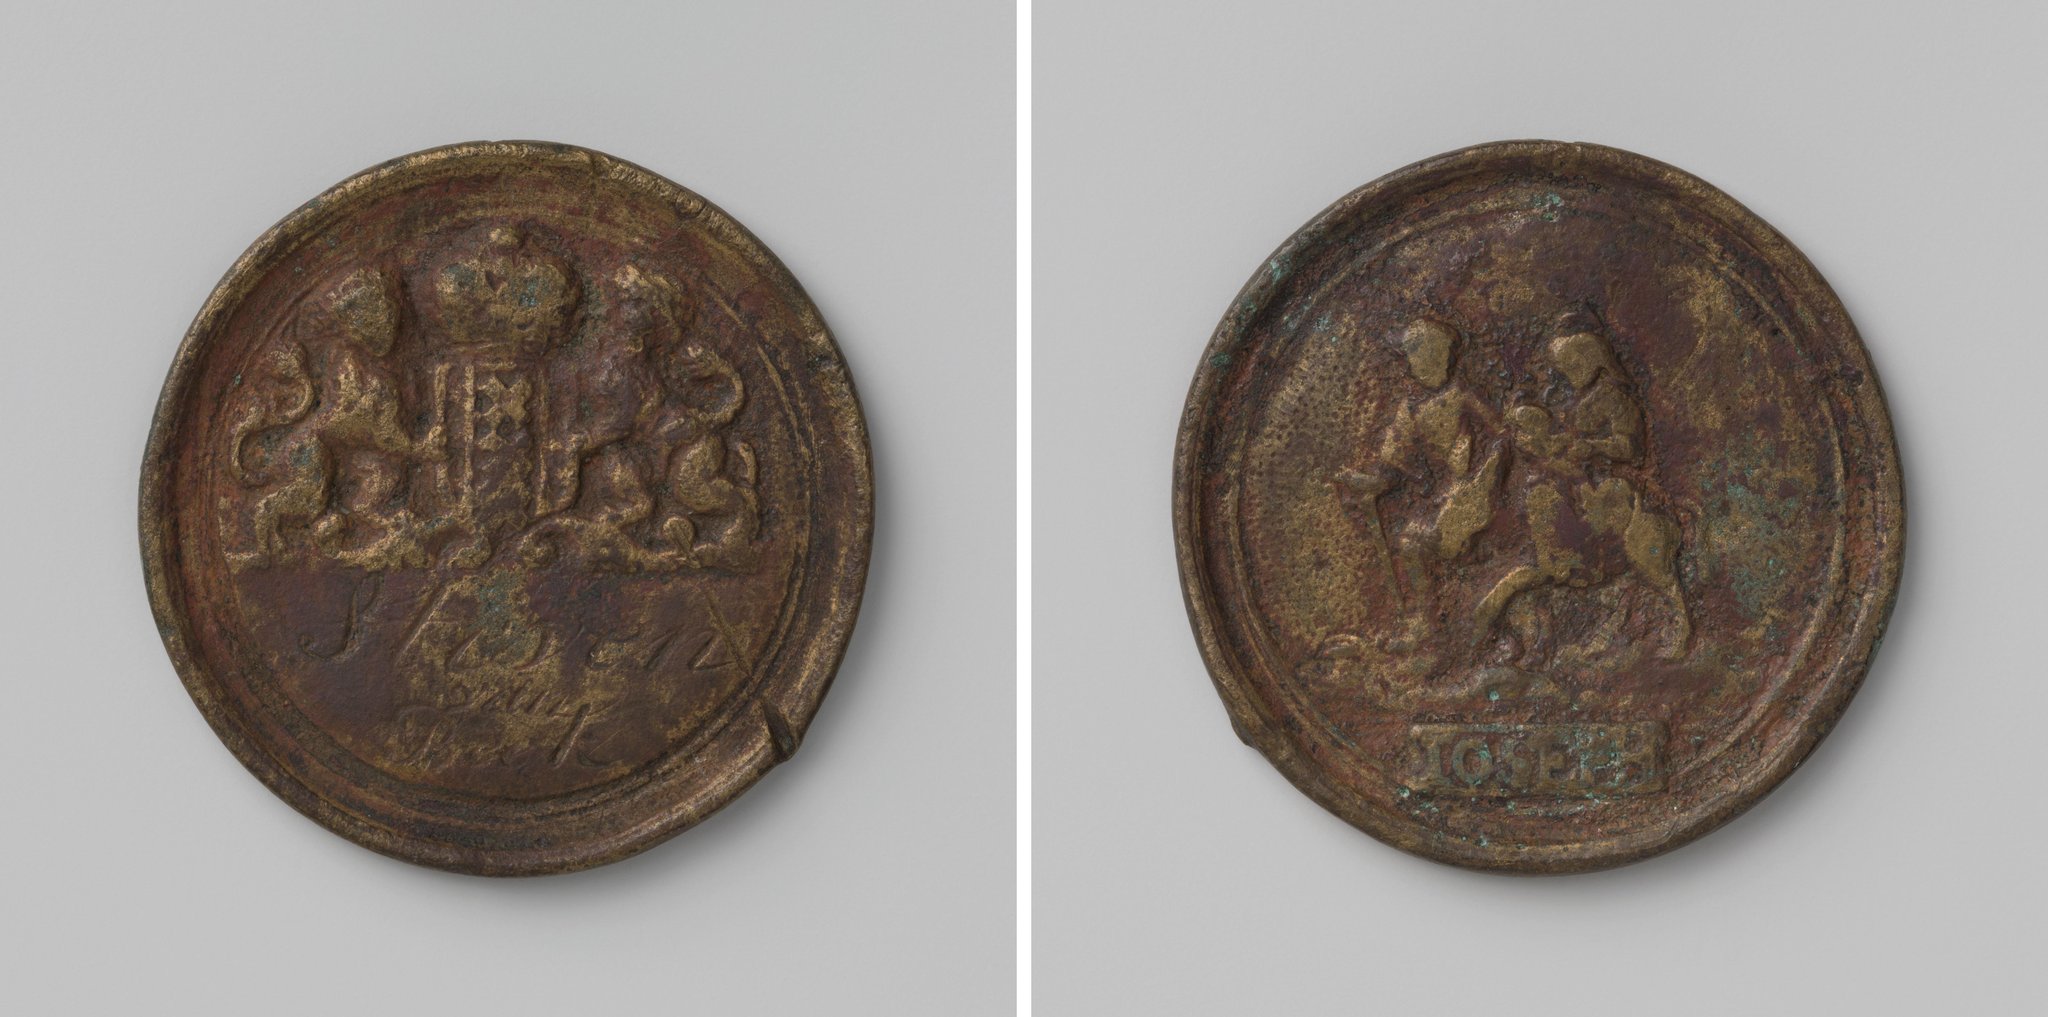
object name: medal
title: Timmerliedengilde van Amsterdam, gildepenning van Steven van Beek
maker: Anonymous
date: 1749-1808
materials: brass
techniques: casting, engraving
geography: amsterdam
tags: amsterdam